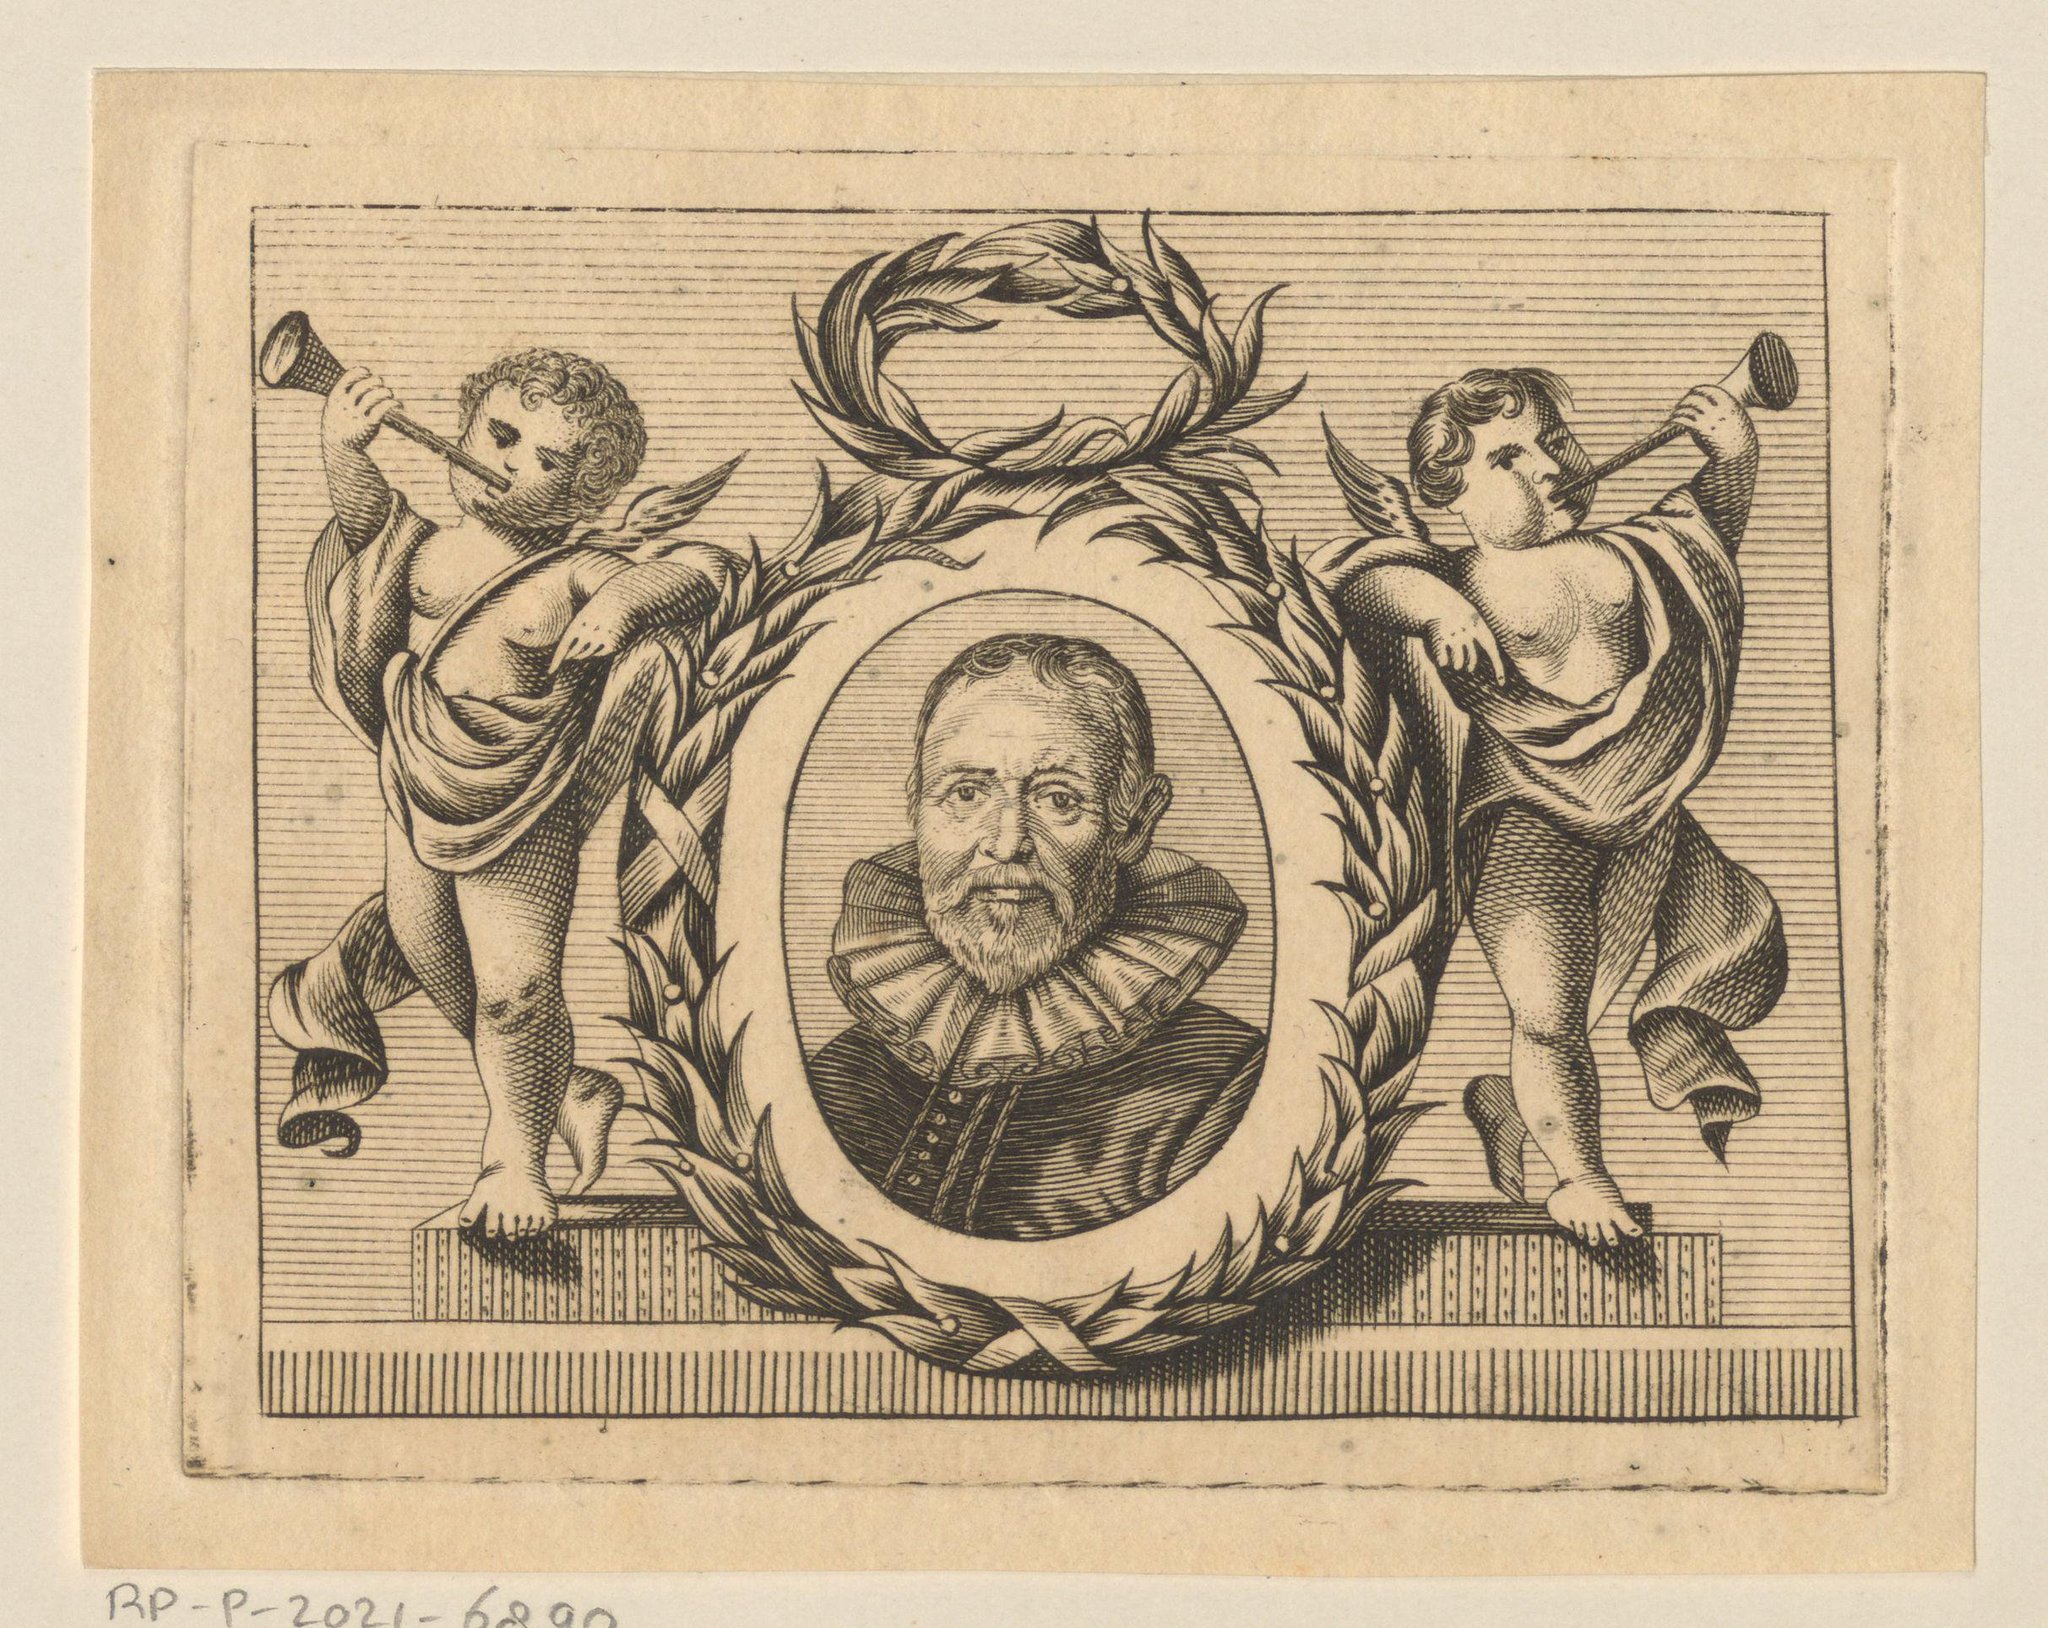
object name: print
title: Portret van Jan van Hout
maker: Anonymous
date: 1701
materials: paper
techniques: engraving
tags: leiden, honouring the artist with laurel wreath, historical persons, portrait of a writer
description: Andere staat van de prent gebruikt in: Pars, Adriaan. Index Batavicus, of naamrol van de Batavise en Hollandse schrijvers (...). Leiden: Abraham de Swart, 1701, p. 162.